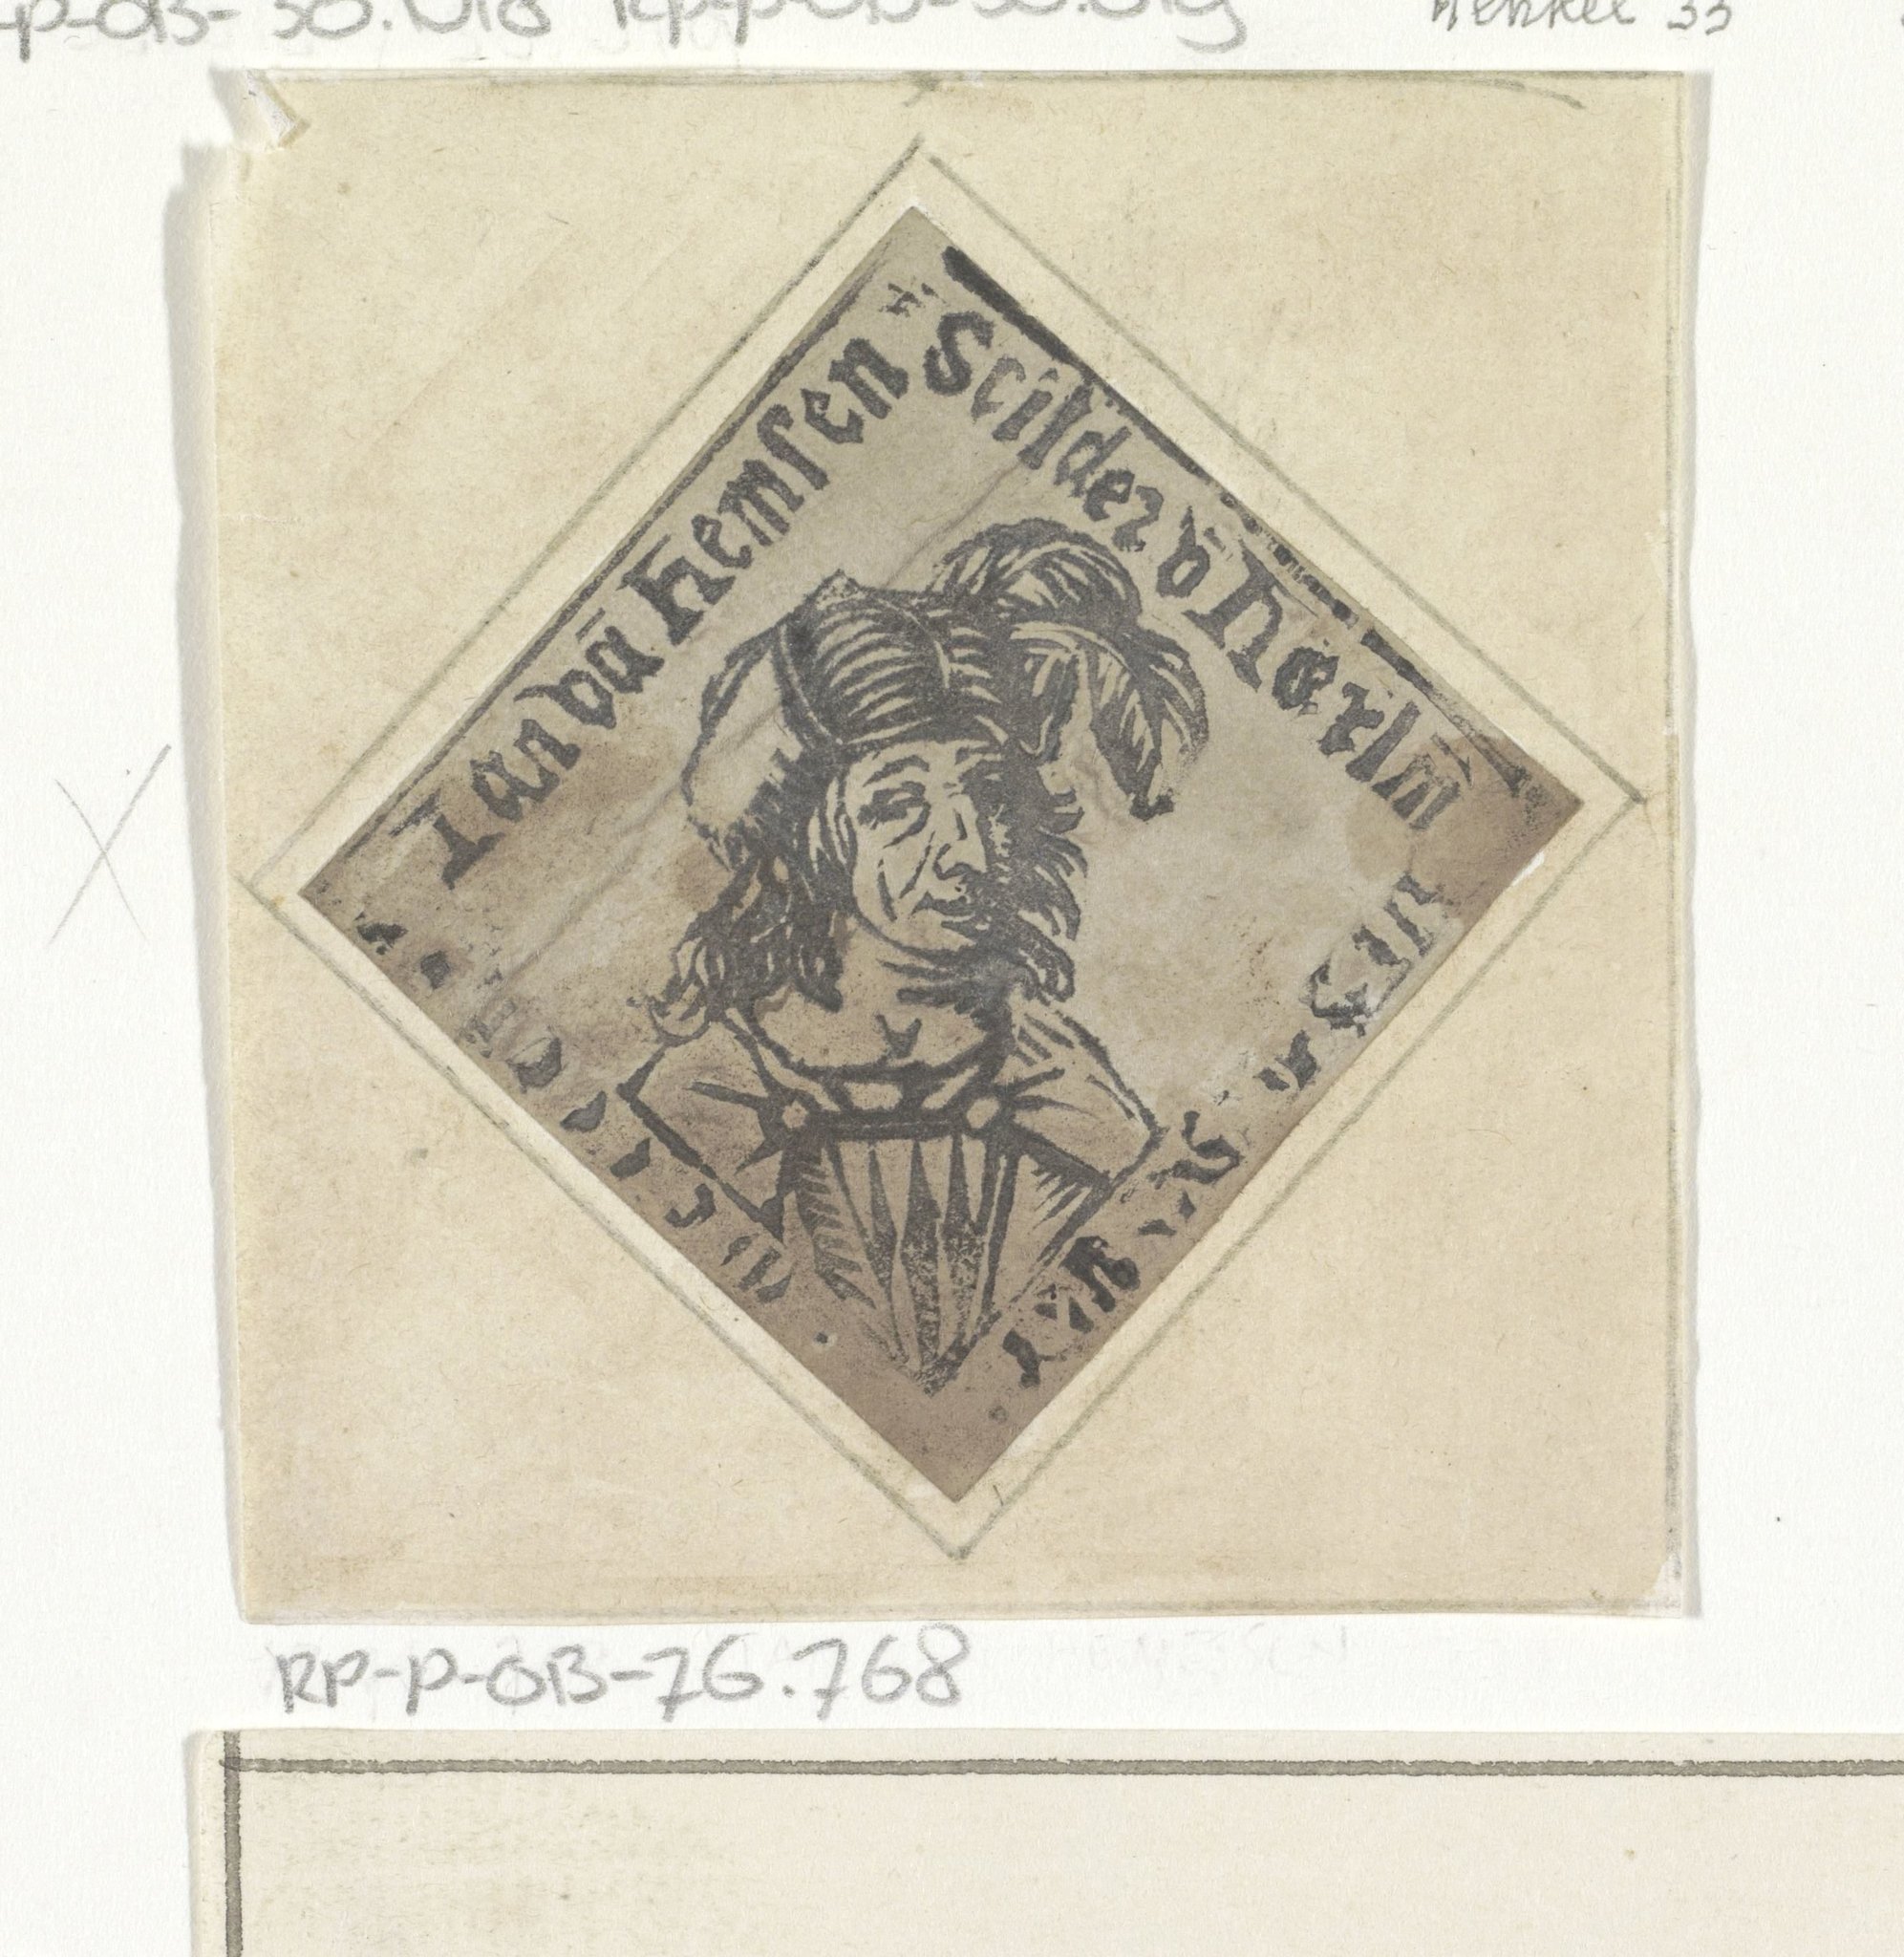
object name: print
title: Portret van Jan van Hemessen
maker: cornelis van den berg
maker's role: draughtsman, print maker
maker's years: 1699-1774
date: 1720-1774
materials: paper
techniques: woodcut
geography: haarlem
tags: painter, jan van hemessen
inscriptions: collector's mark: Lugt 1838, collector's mark: Lugt 240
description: Portret van Jan van Hemessen in een ruit van Nederlandse tekst.